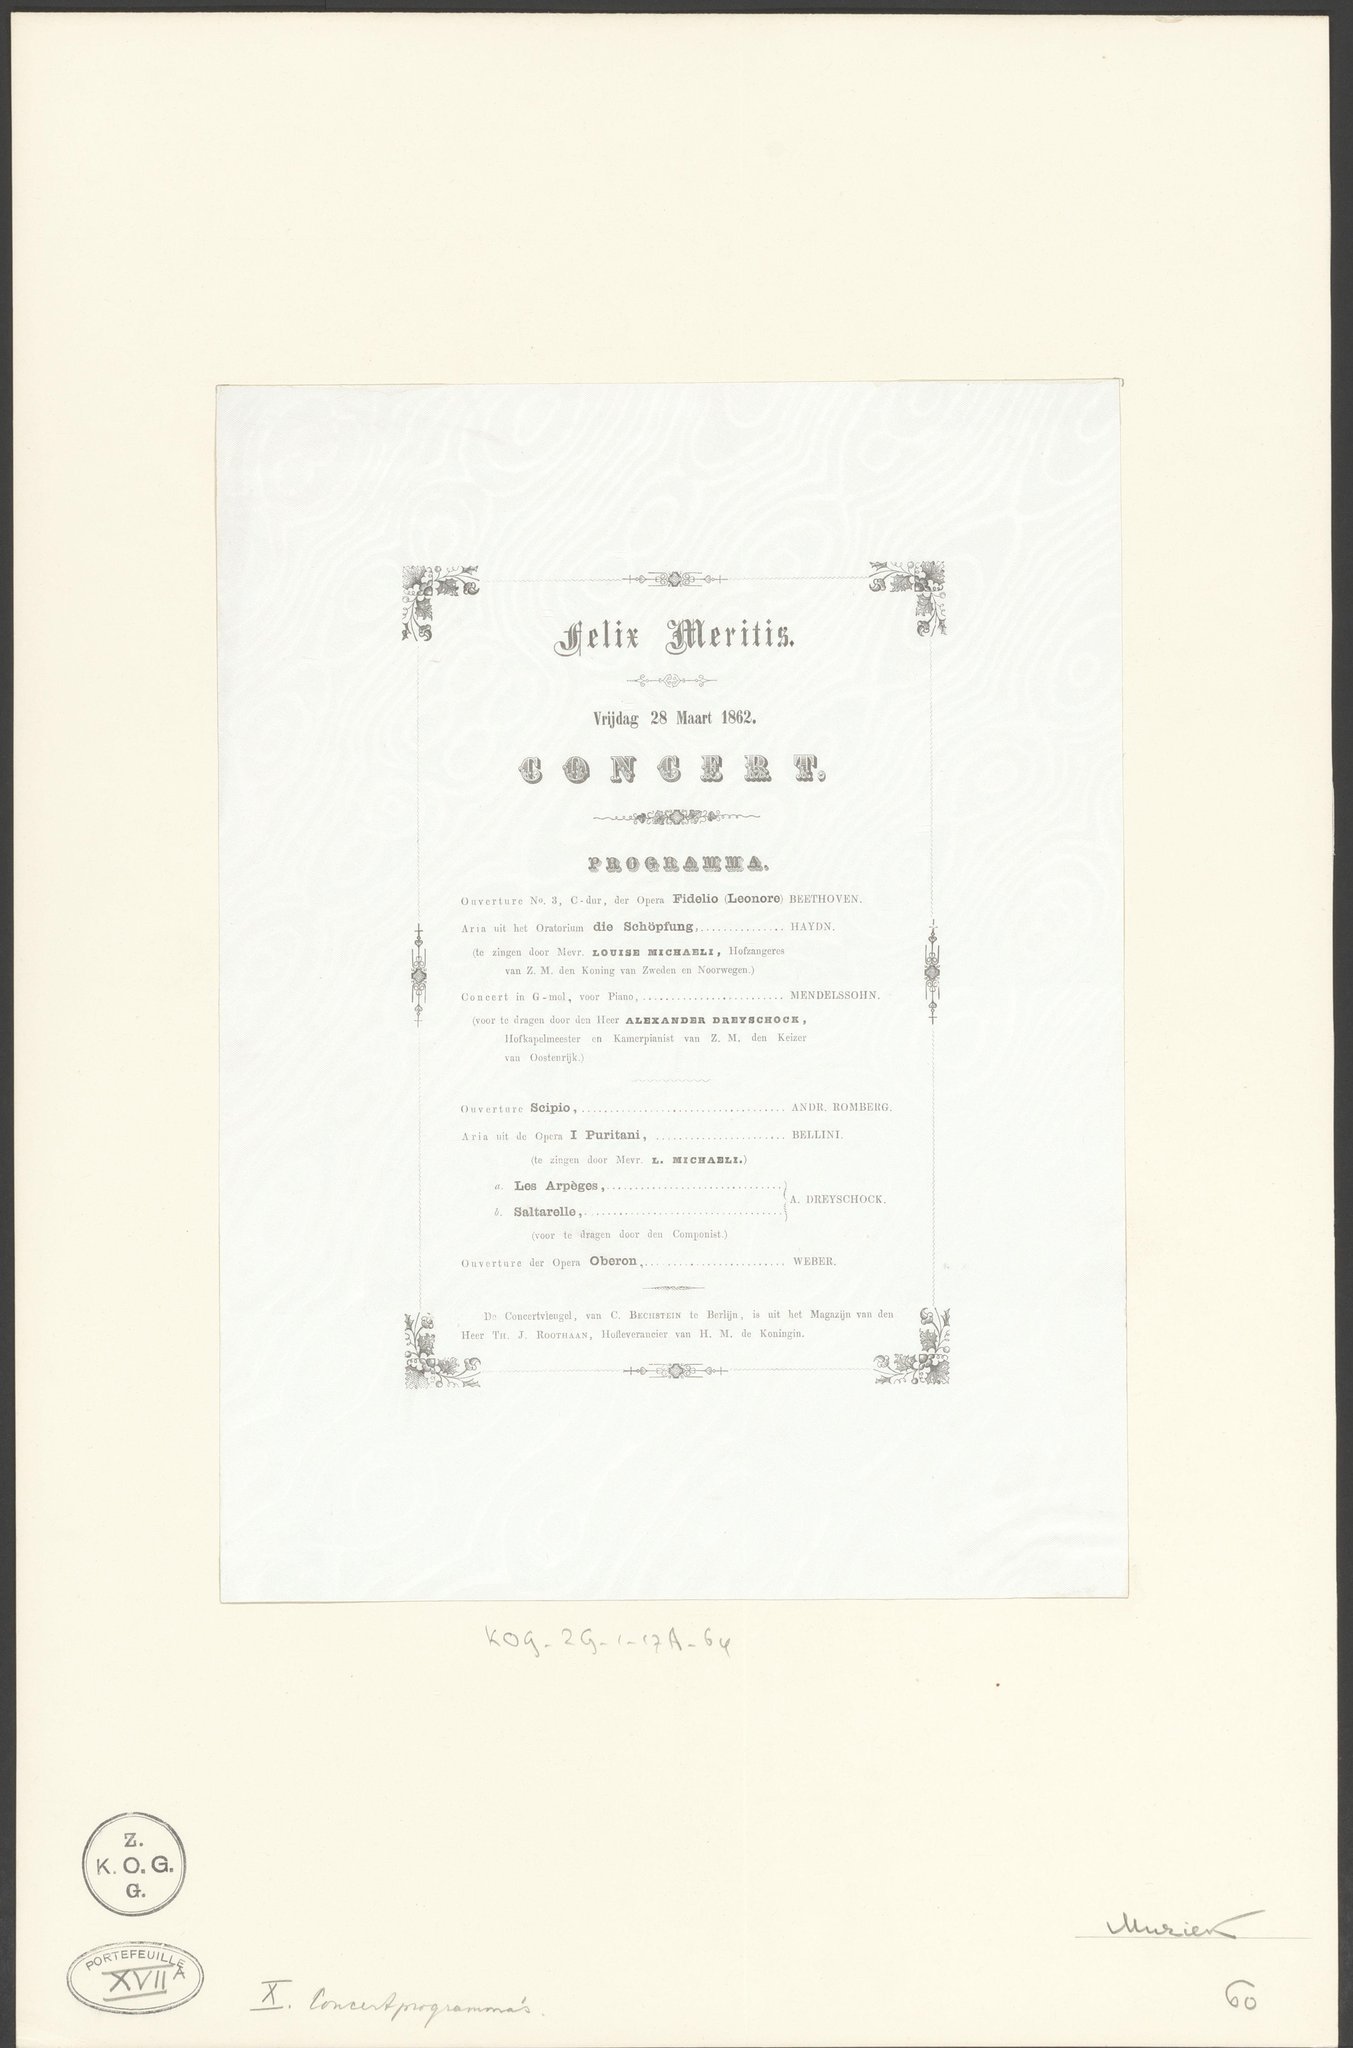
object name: text sheet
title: Programma voor een concert in Felix Meritis op 28 maart 1862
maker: Anonymous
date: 1862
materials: paper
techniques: letterpress printing, moire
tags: listening to music, large group of musicians, orchestra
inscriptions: collector's mark, collector's mark: Lugt 1641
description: Gedrukt programma voor een concert in Felix Meritis op 28 maart 1862. Onderwerpsrubrieken binnen de Atlas Zeden en Gewoonten: Muziek en muziekinstrumenten: Varia.